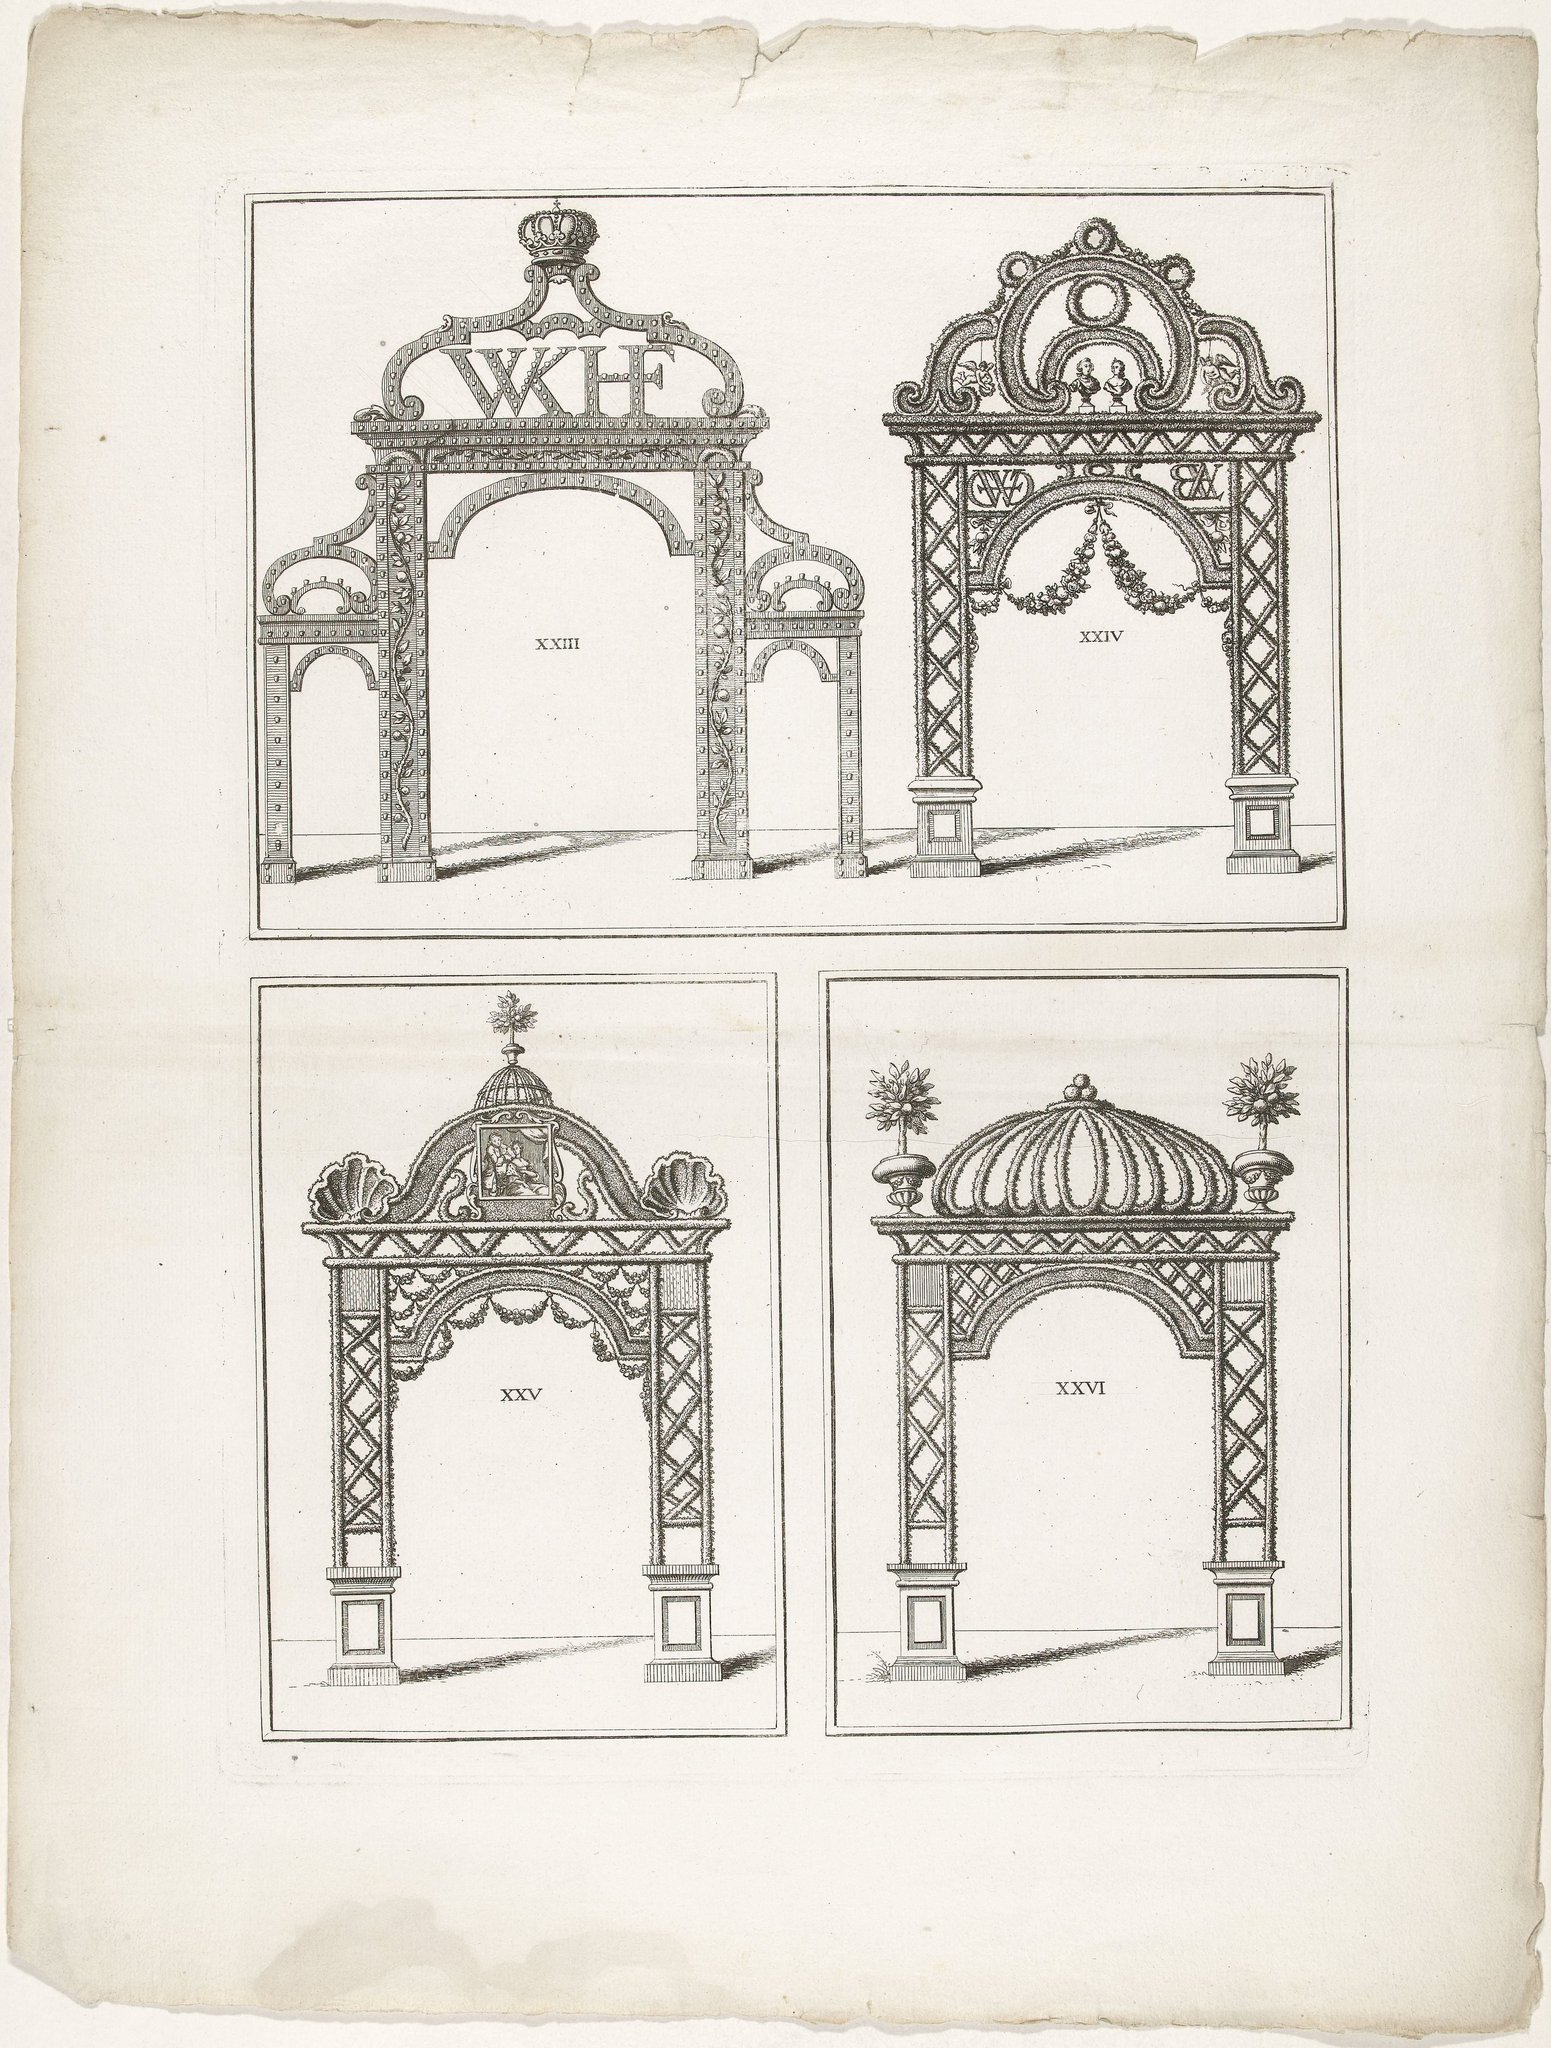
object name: print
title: Nette afbeelding en ampele beschryving der eere-poorten, opgerecht by de blyde te rug komst van wyle (...) Willem Karel Hendrik Friso, prince van Oranje en Nassau (...) uyt Zeeland, en deszelfs intreede in 'sGravenhage, op den 6 juny 1747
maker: albertus frese (de jonge)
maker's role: draughtsman, painter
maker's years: 1714-1788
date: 1766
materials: paper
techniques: etching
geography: northern netherlands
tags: willem iv (prins van oranje-nassau), triumphal arch, the hague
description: Blad met de erepoorten genummerd XXIII-XXVI. Los blad oorspronkelijk onderdeel van het plaatwerk Nette afbeelding en ampele beschrijving der eere-poorten uit 1766 met voorstellingen van de erepoorten en triomfbogen opgesteld te Den Haag tijdens de feestelijkheden rond de intrede van prins Willem IV als stadhouder van Holland en West-Friesland op 6 juni 1747.